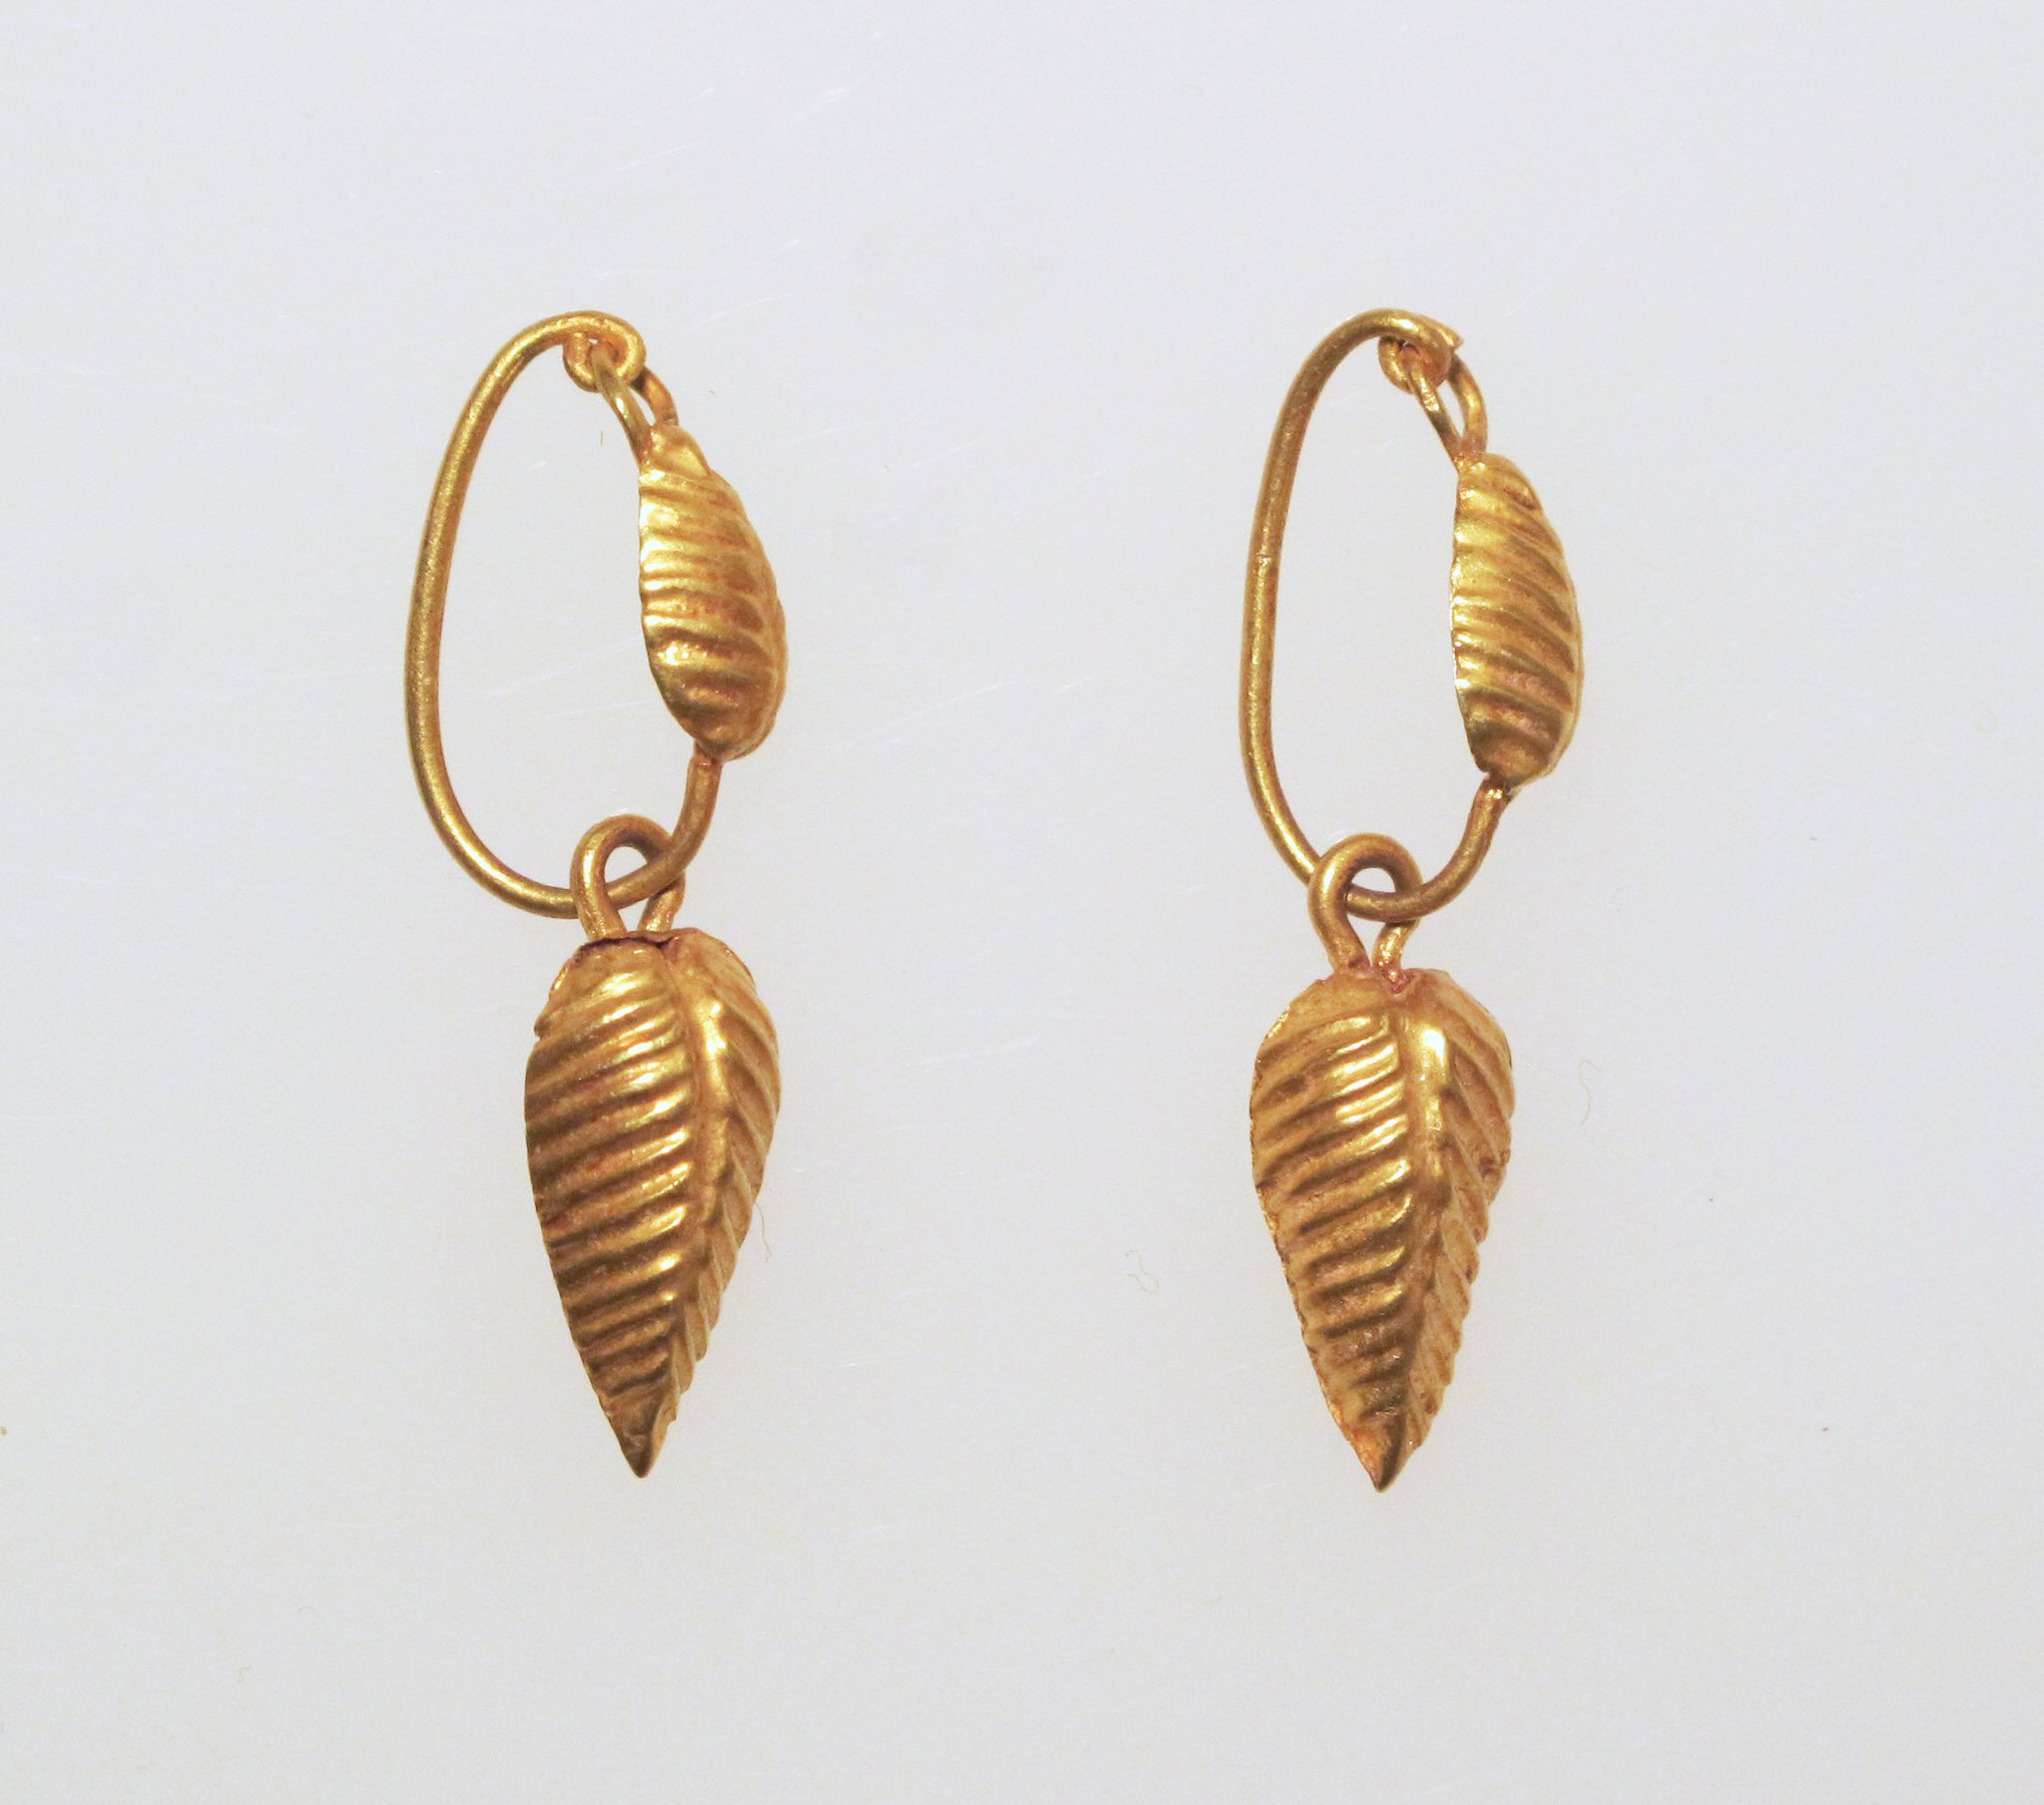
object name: earring with pendant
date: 7000 BCE-330 CE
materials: gold